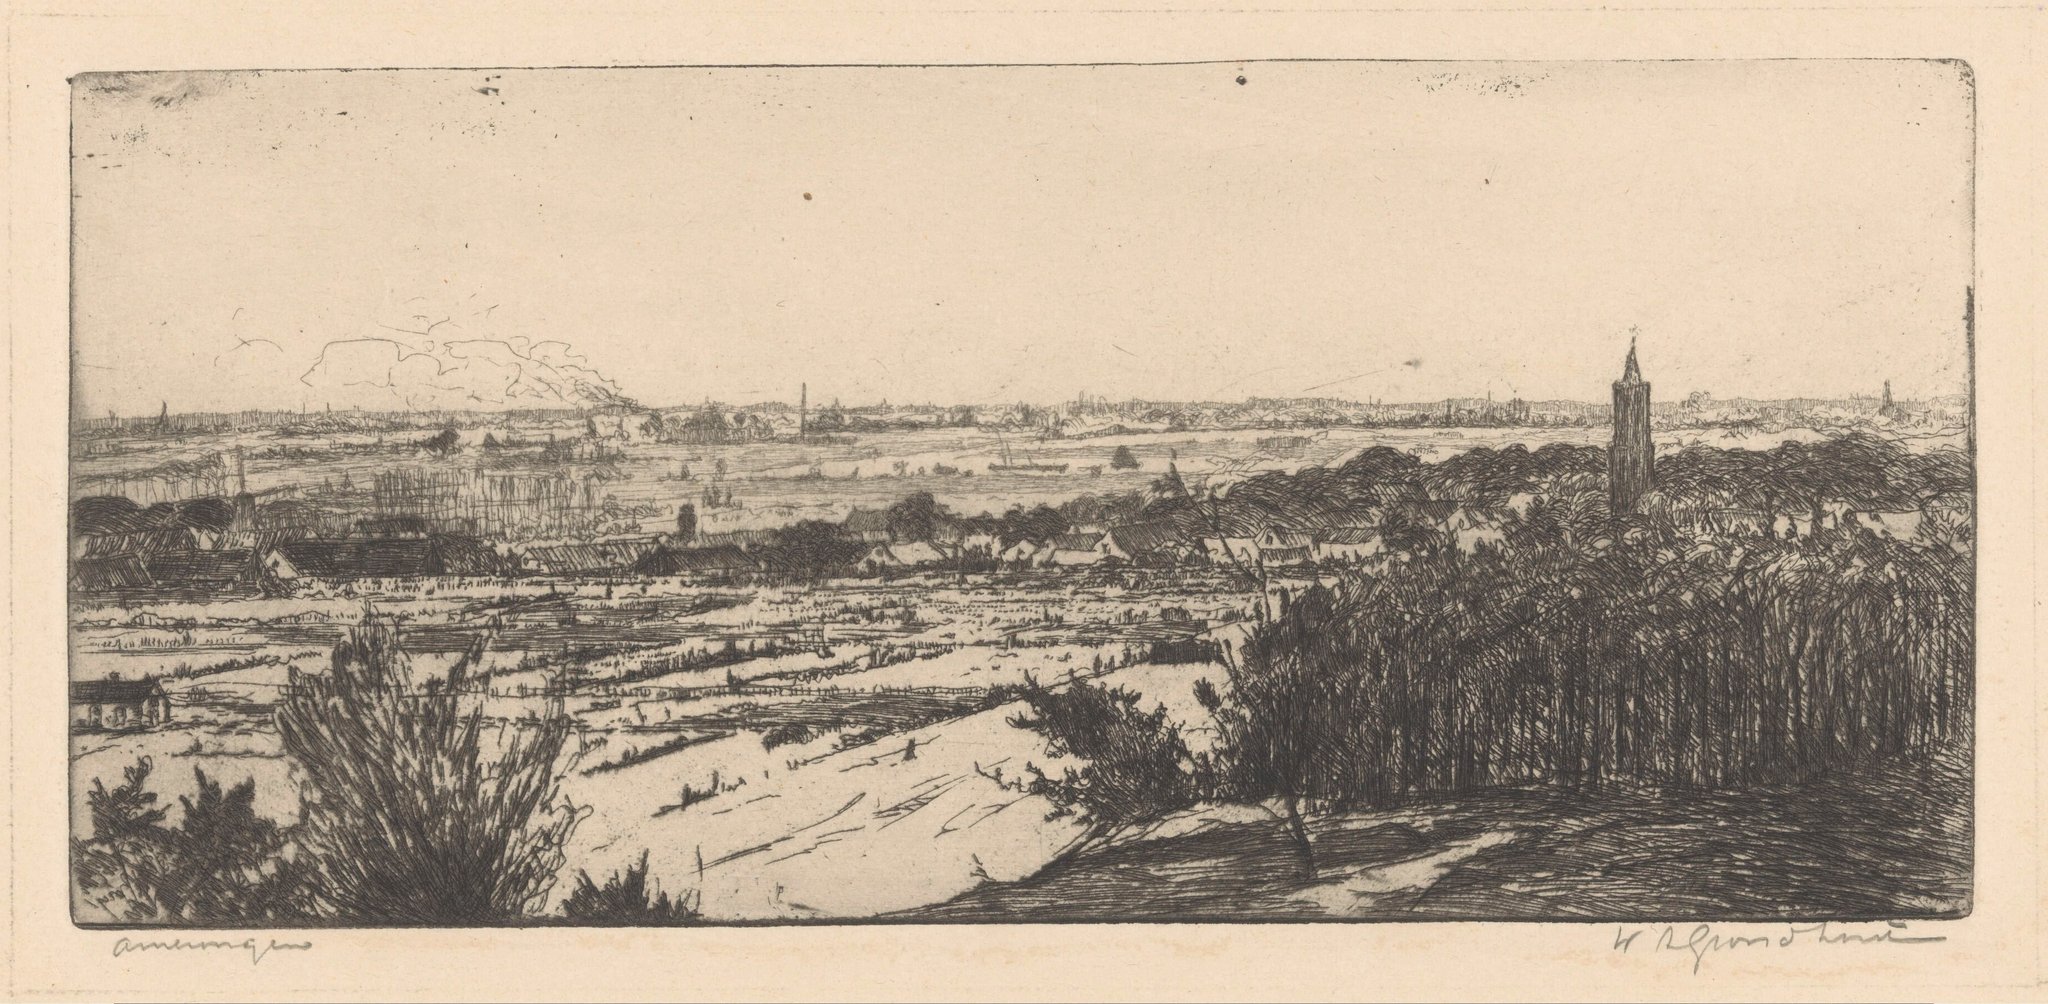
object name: print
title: Amerongen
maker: willem adrianus grondhout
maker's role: draughtsman, painter, print maker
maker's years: 1878-1934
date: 1888-1934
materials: paper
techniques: etching, intaglio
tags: city-view, and landscape with man-made constructions, amerongen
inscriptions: collector's mark: Lugt 2228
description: Het dorp Amerongen en het omliggende gebied in de provincie Utrecht. Links korenmolen Maallust, rechts de Andrieskerk.